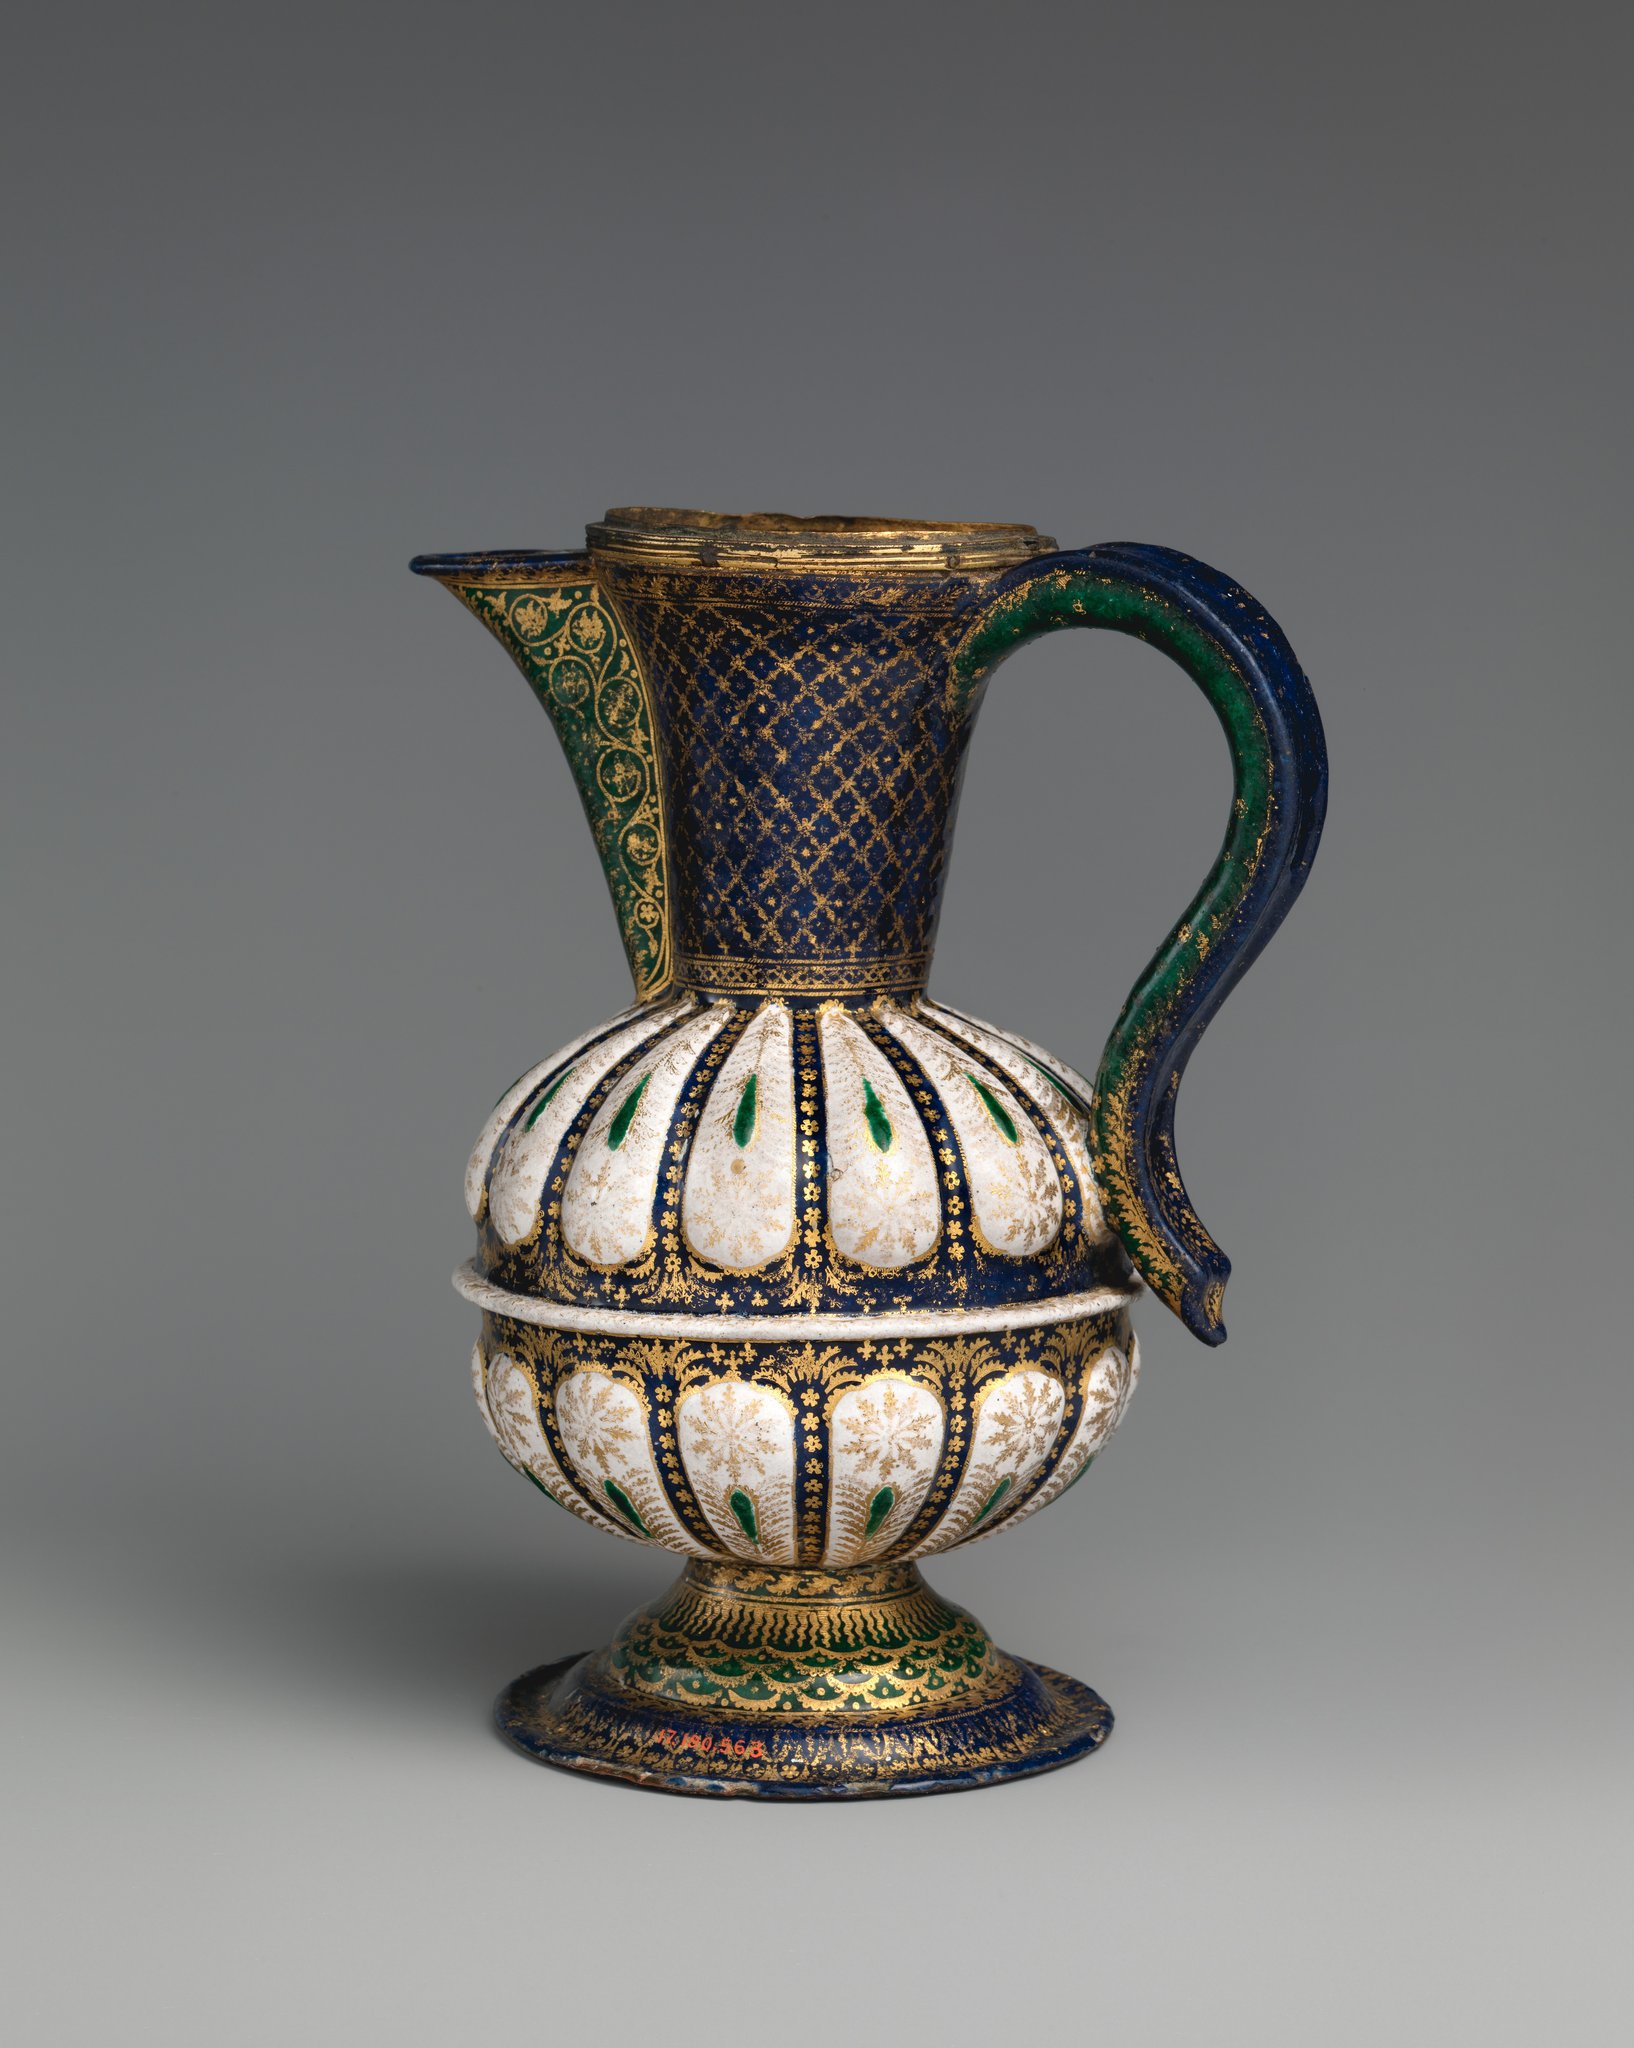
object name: ewer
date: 1467-1533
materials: brass, copper, enamel, gilt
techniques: painting